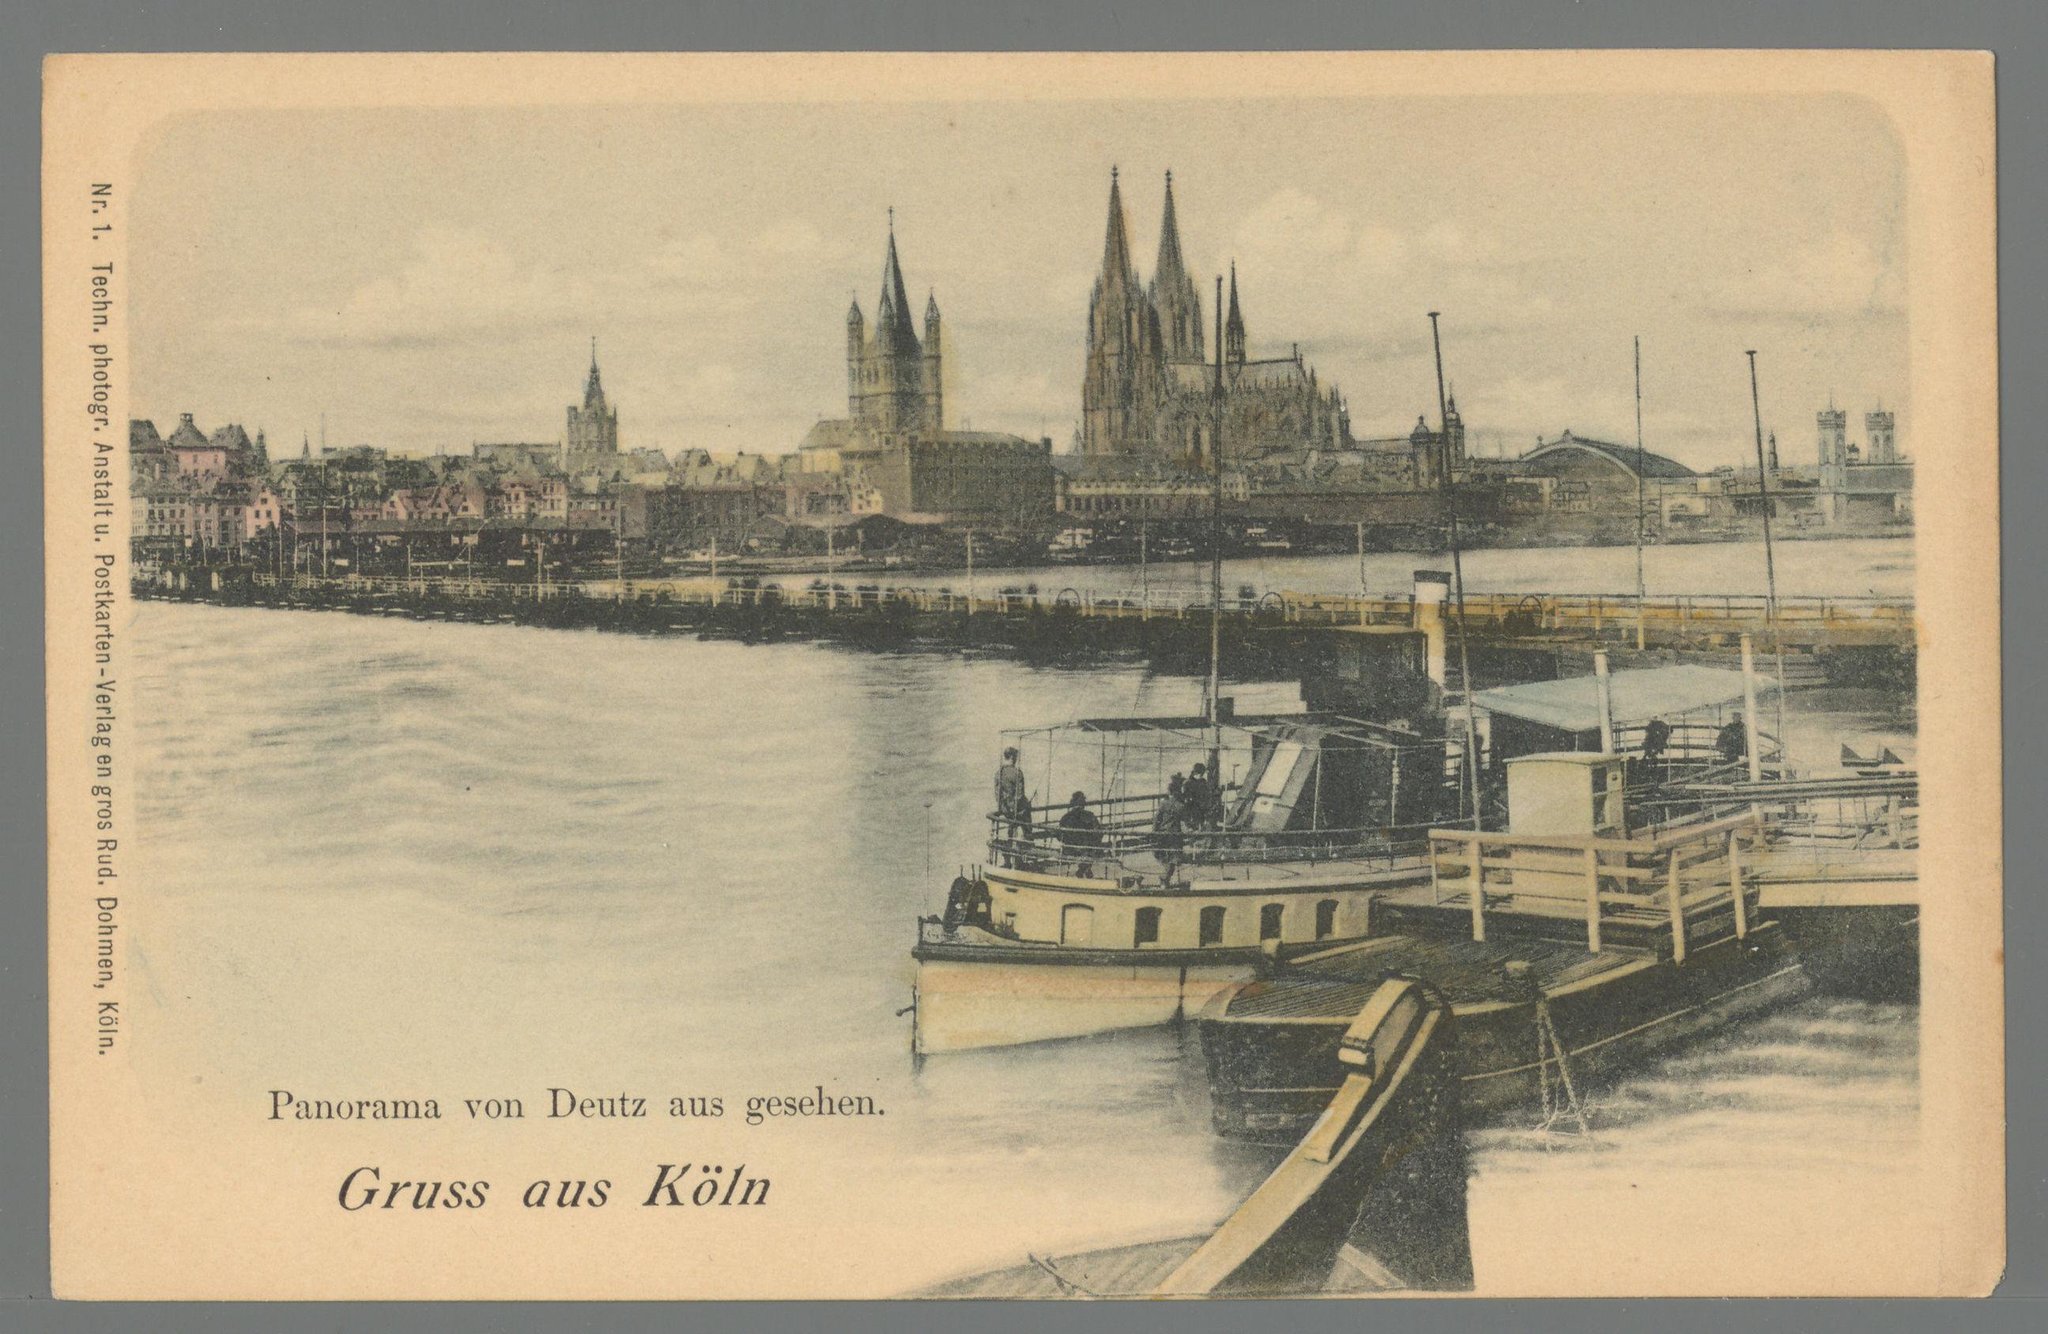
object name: ansichtkaart, prentbriefkaart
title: Panorama von Deutz aus gesehen. Gruss aus Köln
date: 1885-1905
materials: cardboard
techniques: photograph, hand coloring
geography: cologne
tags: church (exterior), canals, waters (in city), bridge in city across river, canal, etc., prospect of city, town panorama, silhouette of city, cologne